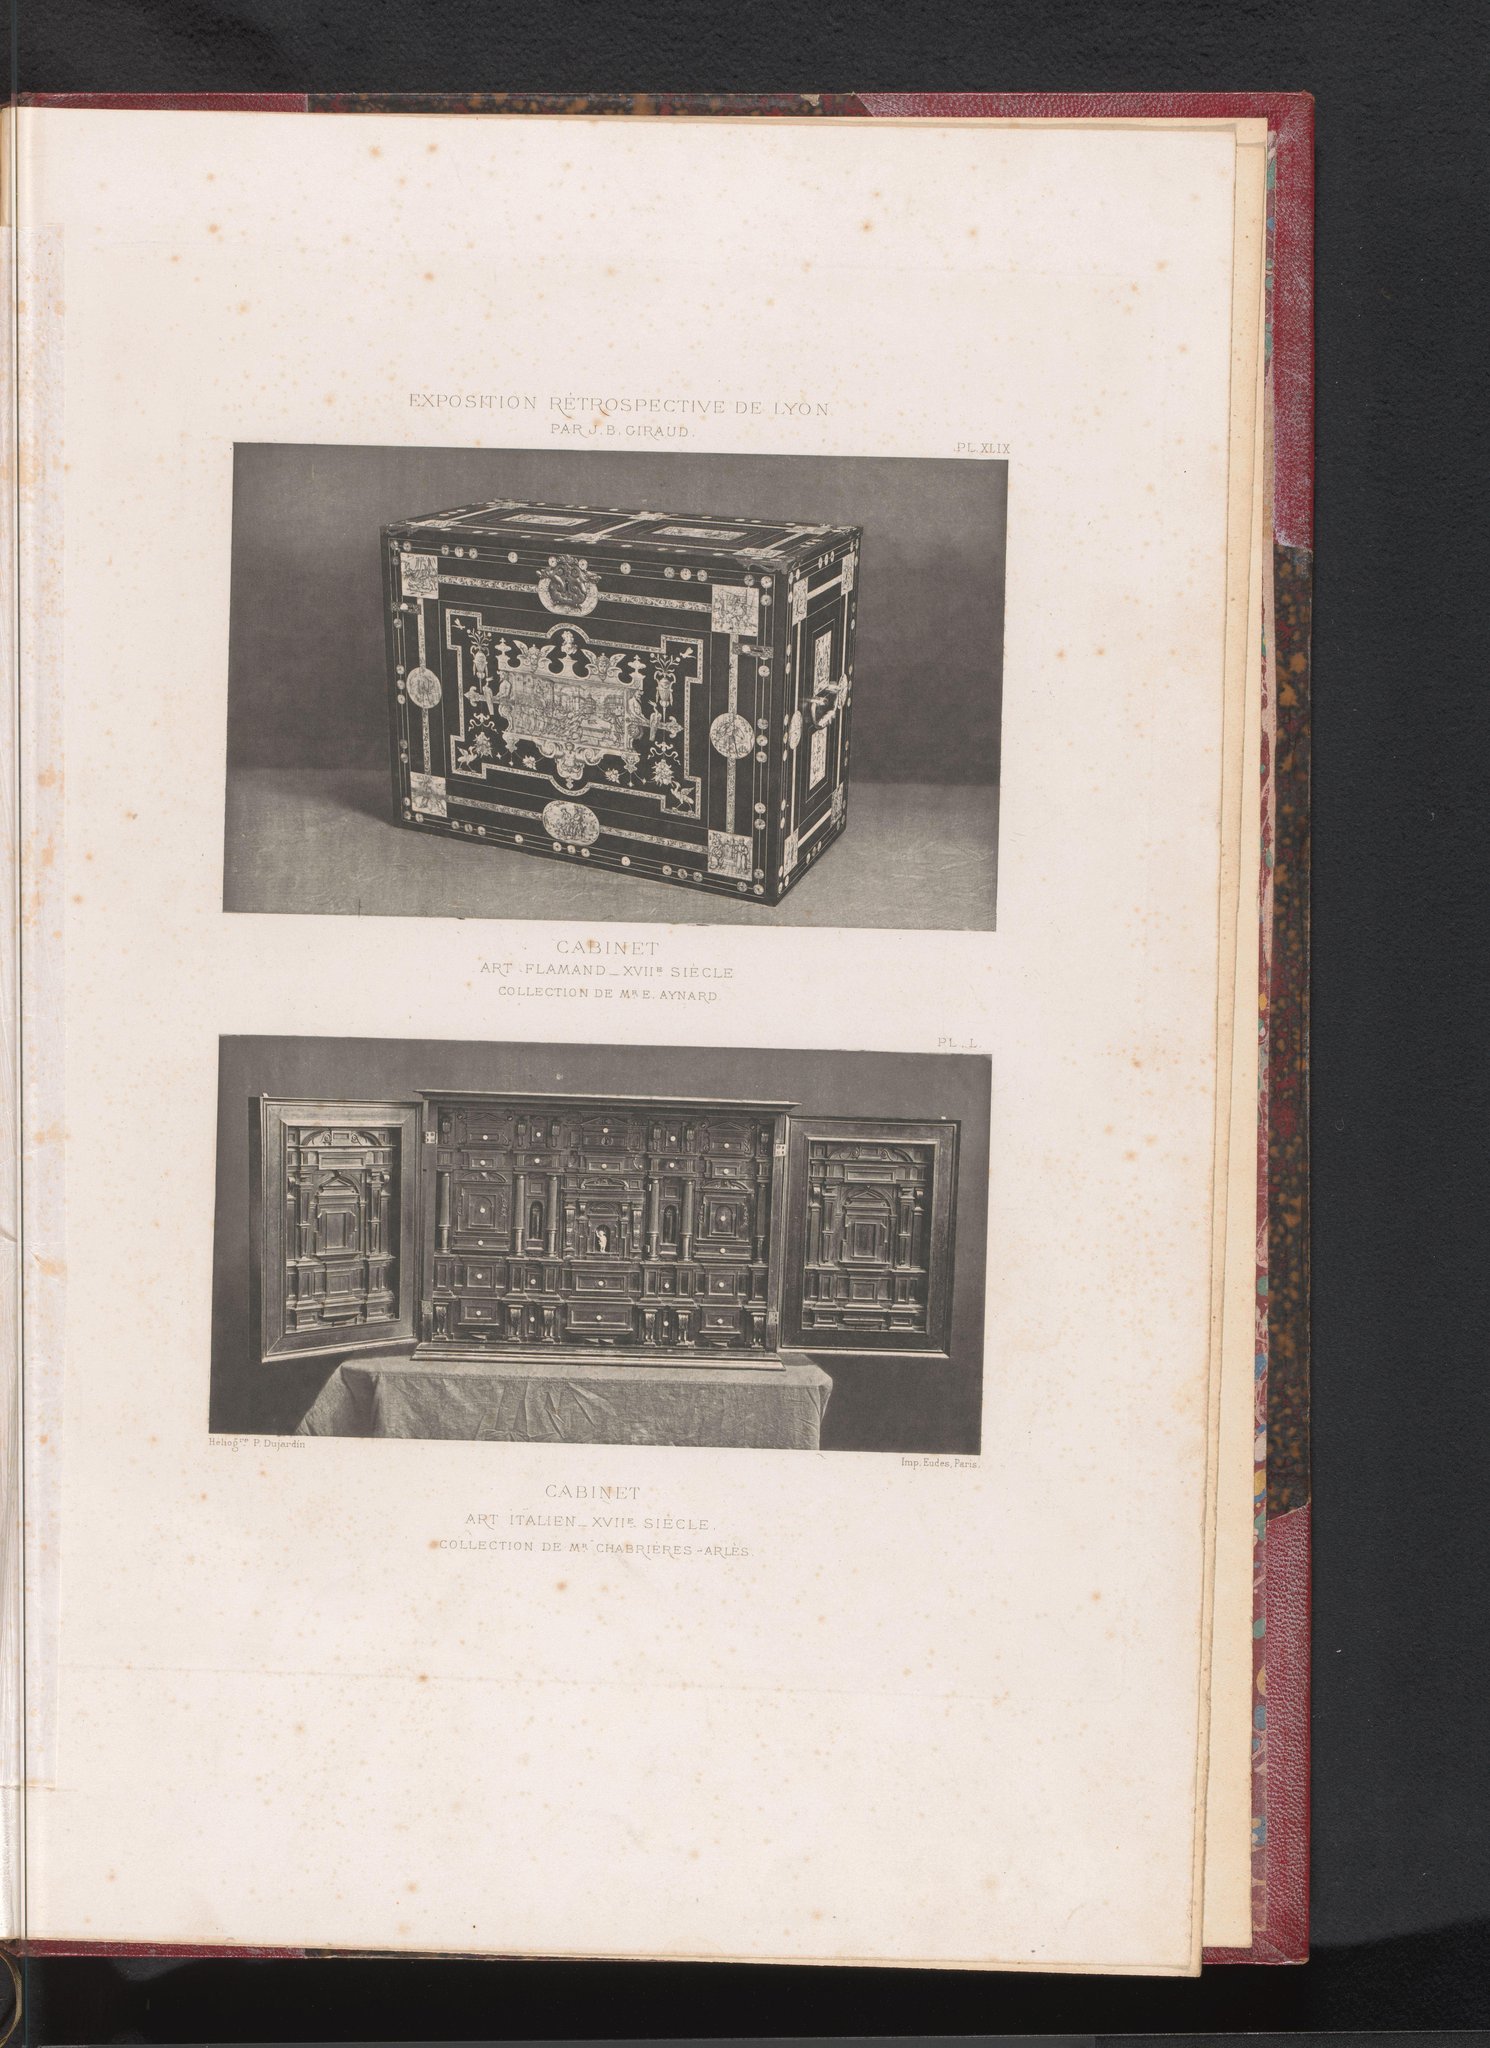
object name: page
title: 17de-eeuws Vlaams kabinet van hout en een 17de-eeuws Italiaans kabinet van hout, op de Exposition Rétrospective van 1877 in Lyon, Frankrijk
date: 1877-1880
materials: paper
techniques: photoaquatint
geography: paris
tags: ornamental cupboard (+ wood and other phytogenic material), lyon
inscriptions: inscription: ‘CABINET/ ART ITALIEN_XVIIe SIÈCLE/ COLLECTION DE Mr CHAMBRIÈRES-ARLÈS.’, number: ‘PL. XLIX.’, number: ‘PL. L.’, inscription: ‘CABINET/ ART FLAMAND_XVIIe SIÈCLE/ COLLECTION DE Mr E. AYNARD.’, inscription: ‘EXPOSITION RÉTROSPECTIVE DE LYON/ PAR J. B. GIRAUD.’